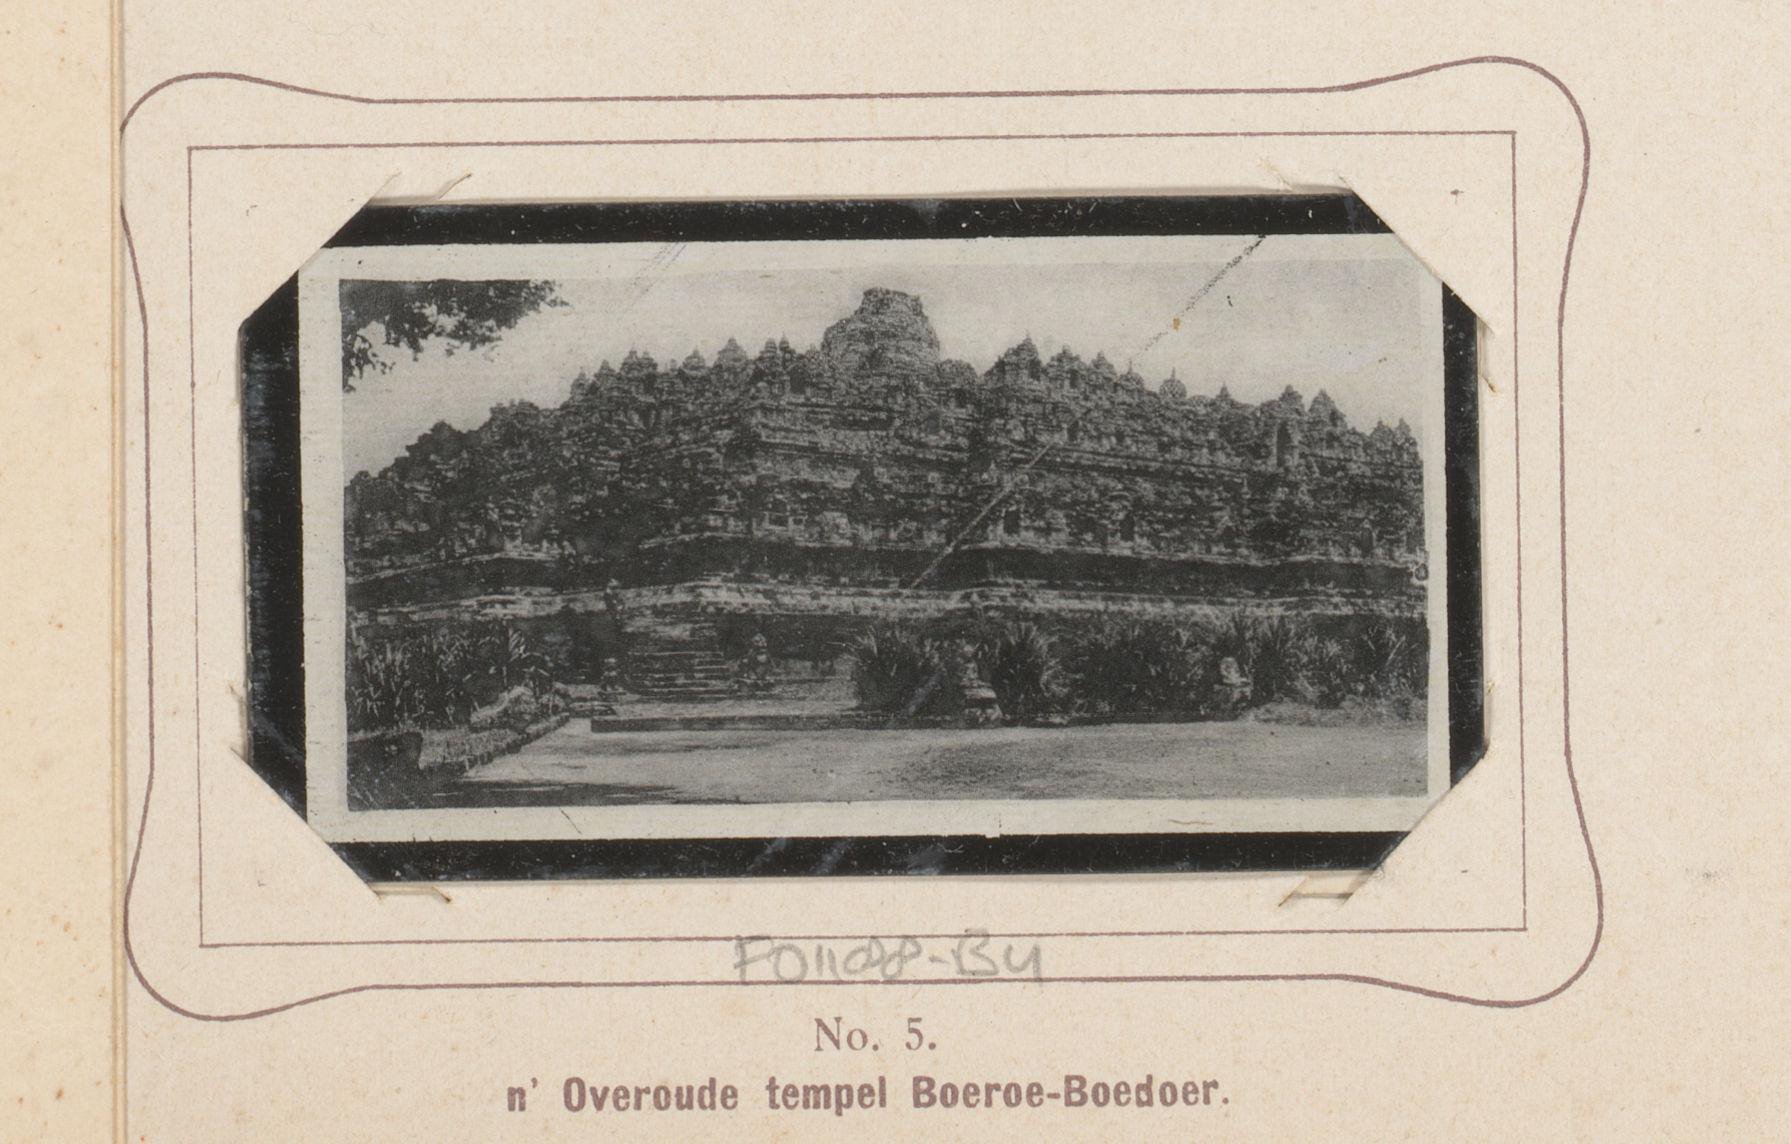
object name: photomechanical print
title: Gezicht op de Borobudur te Indonesië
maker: Anonymous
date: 1906-1907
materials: paper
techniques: photograph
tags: temple, shrine ~ hinduism, buddhism, jainism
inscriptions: inscription: ‘No. 5./ n'Overoude tempel Boeroe-Boedoer.’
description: Deze prent maakt deel uit van een album.